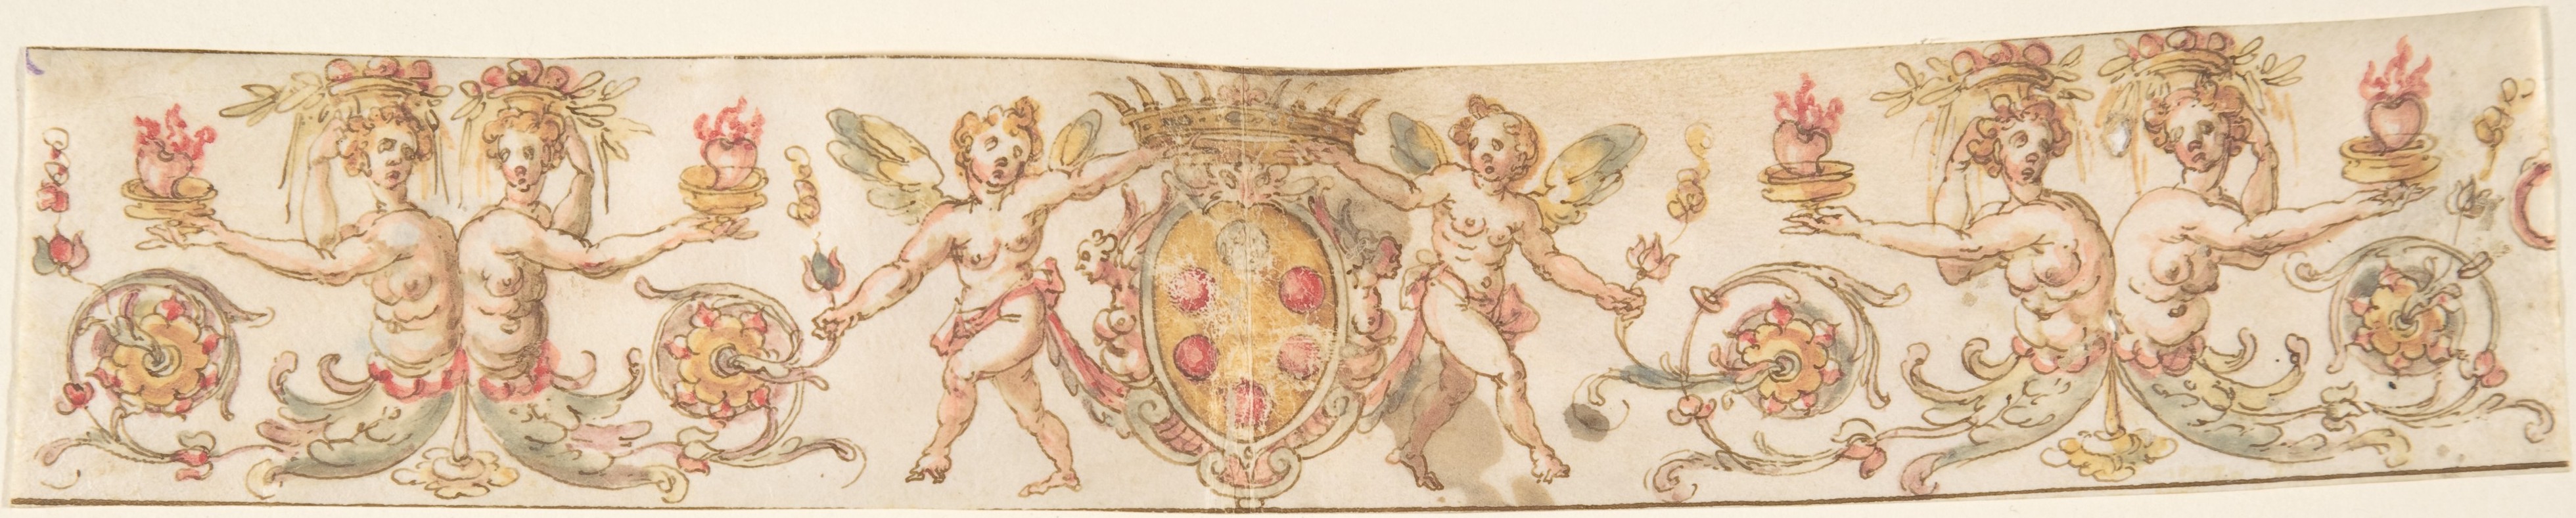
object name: drawing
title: Frieze with Medici Coat of Arms and Putti (Embroidery Design?)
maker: anonymous, italian, 16th century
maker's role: artist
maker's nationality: italian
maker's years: 1500-1600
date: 1501-1600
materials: ink, parchment, watercolor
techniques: pen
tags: ornament,putti,coat of arms